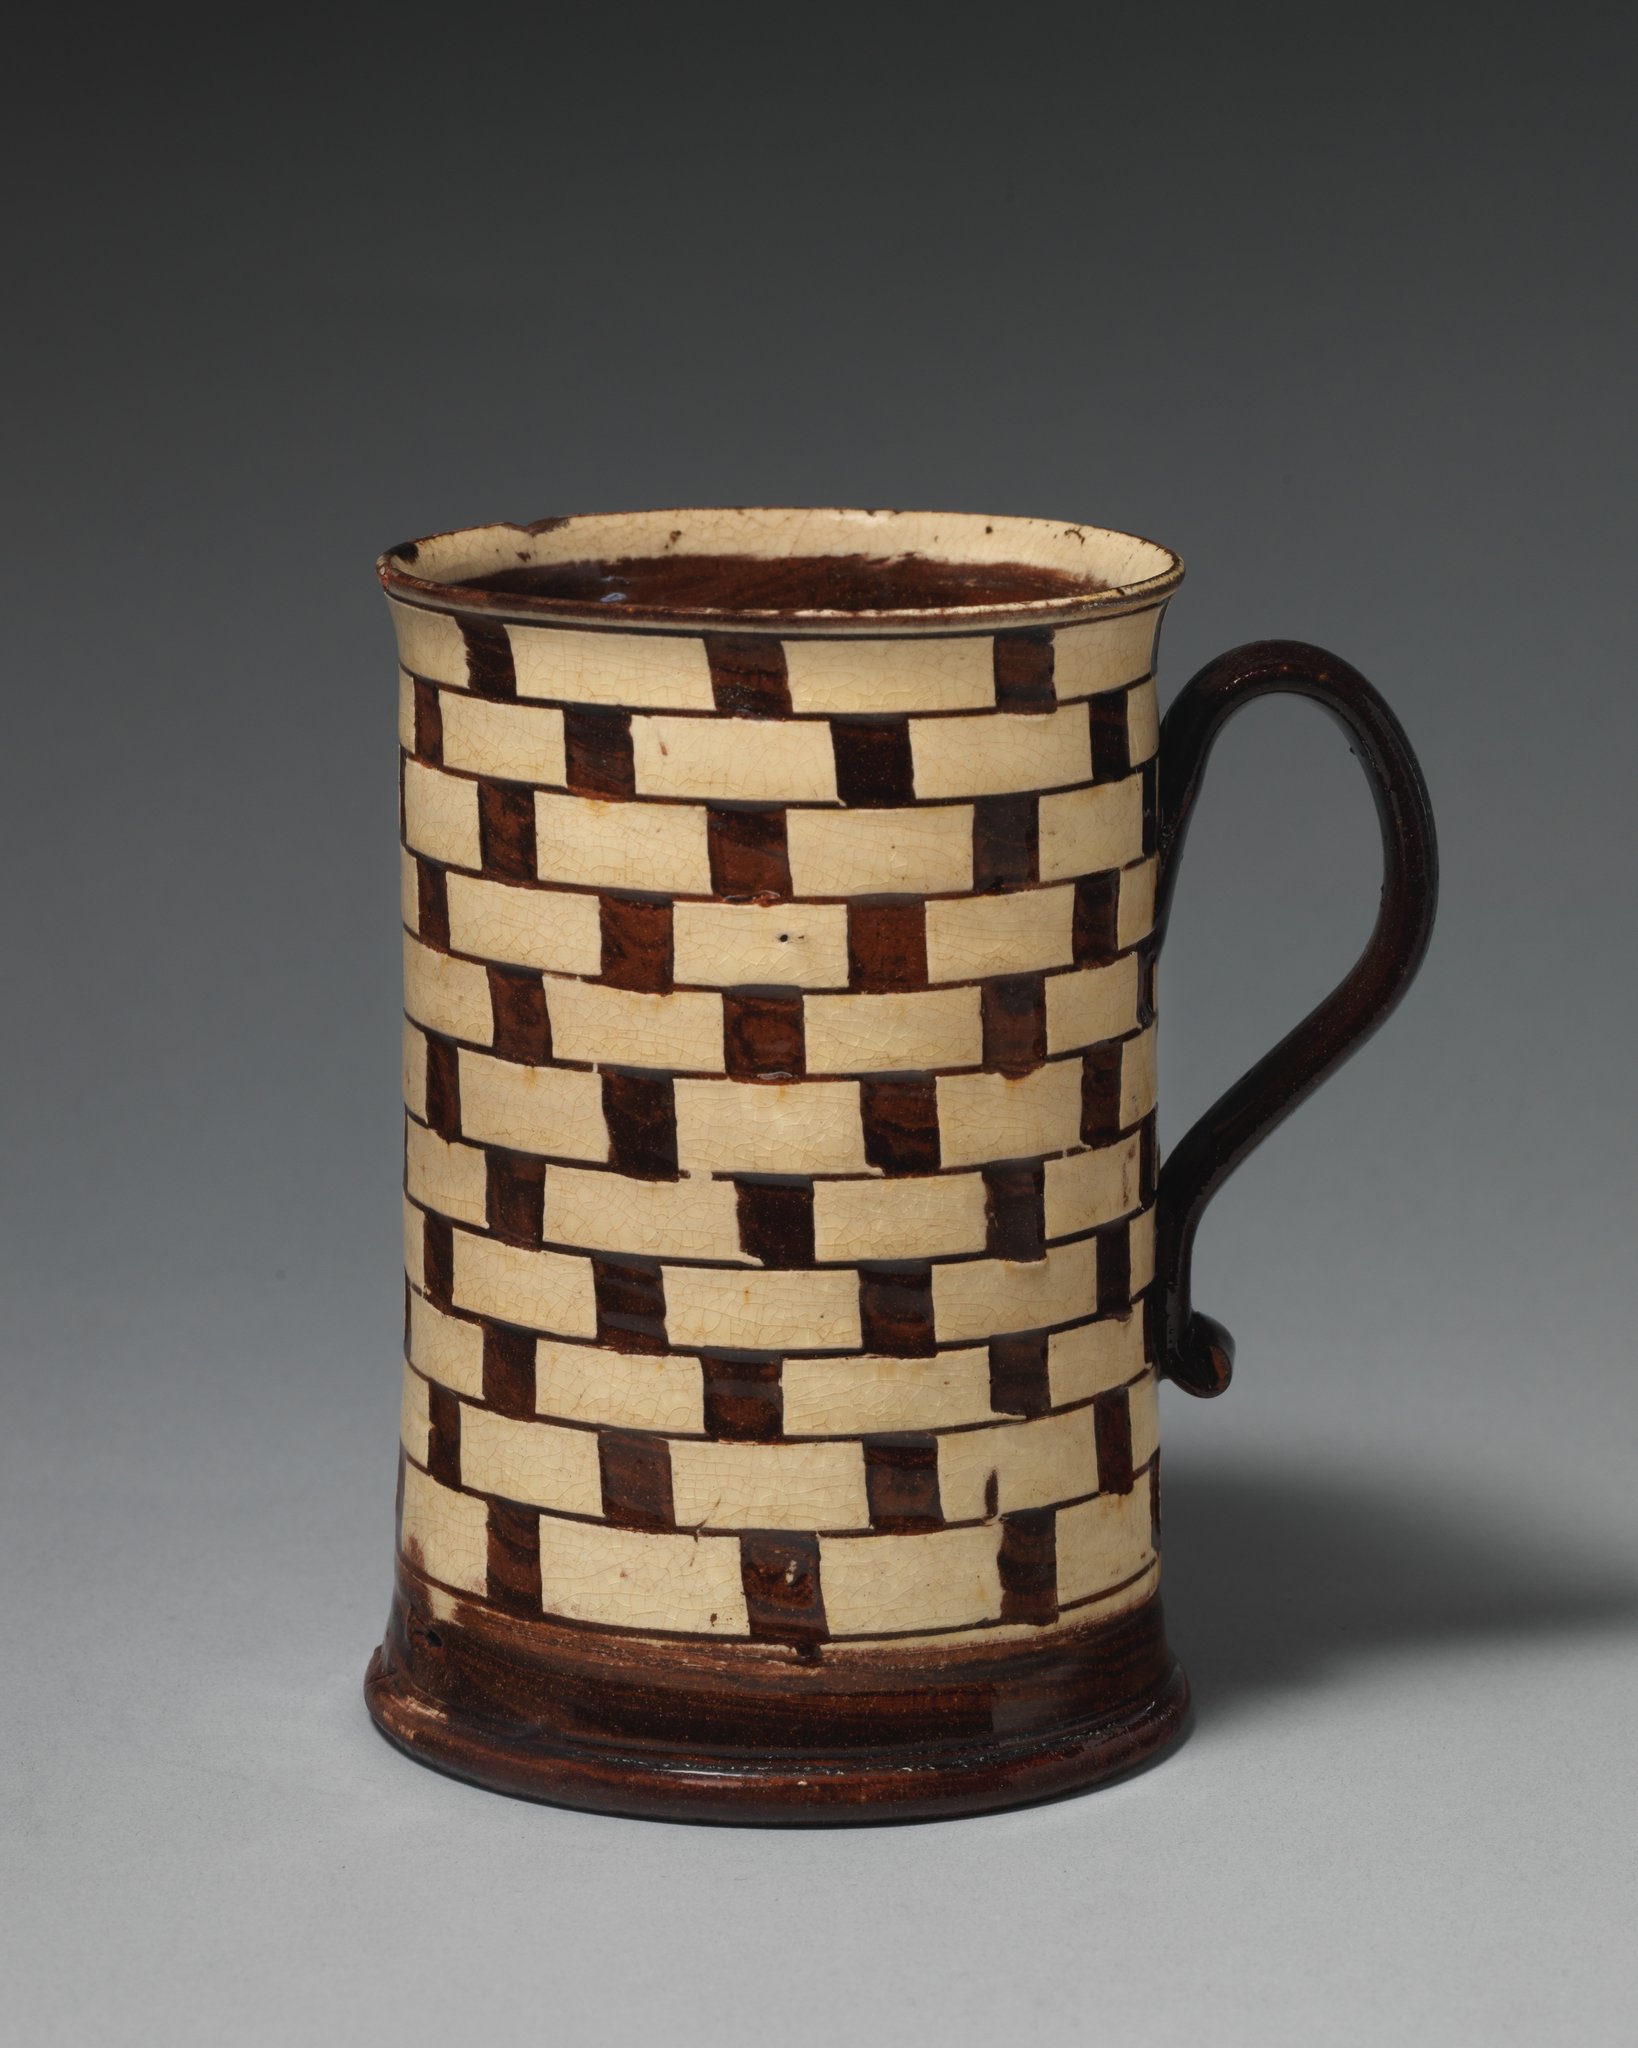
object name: mug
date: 1760